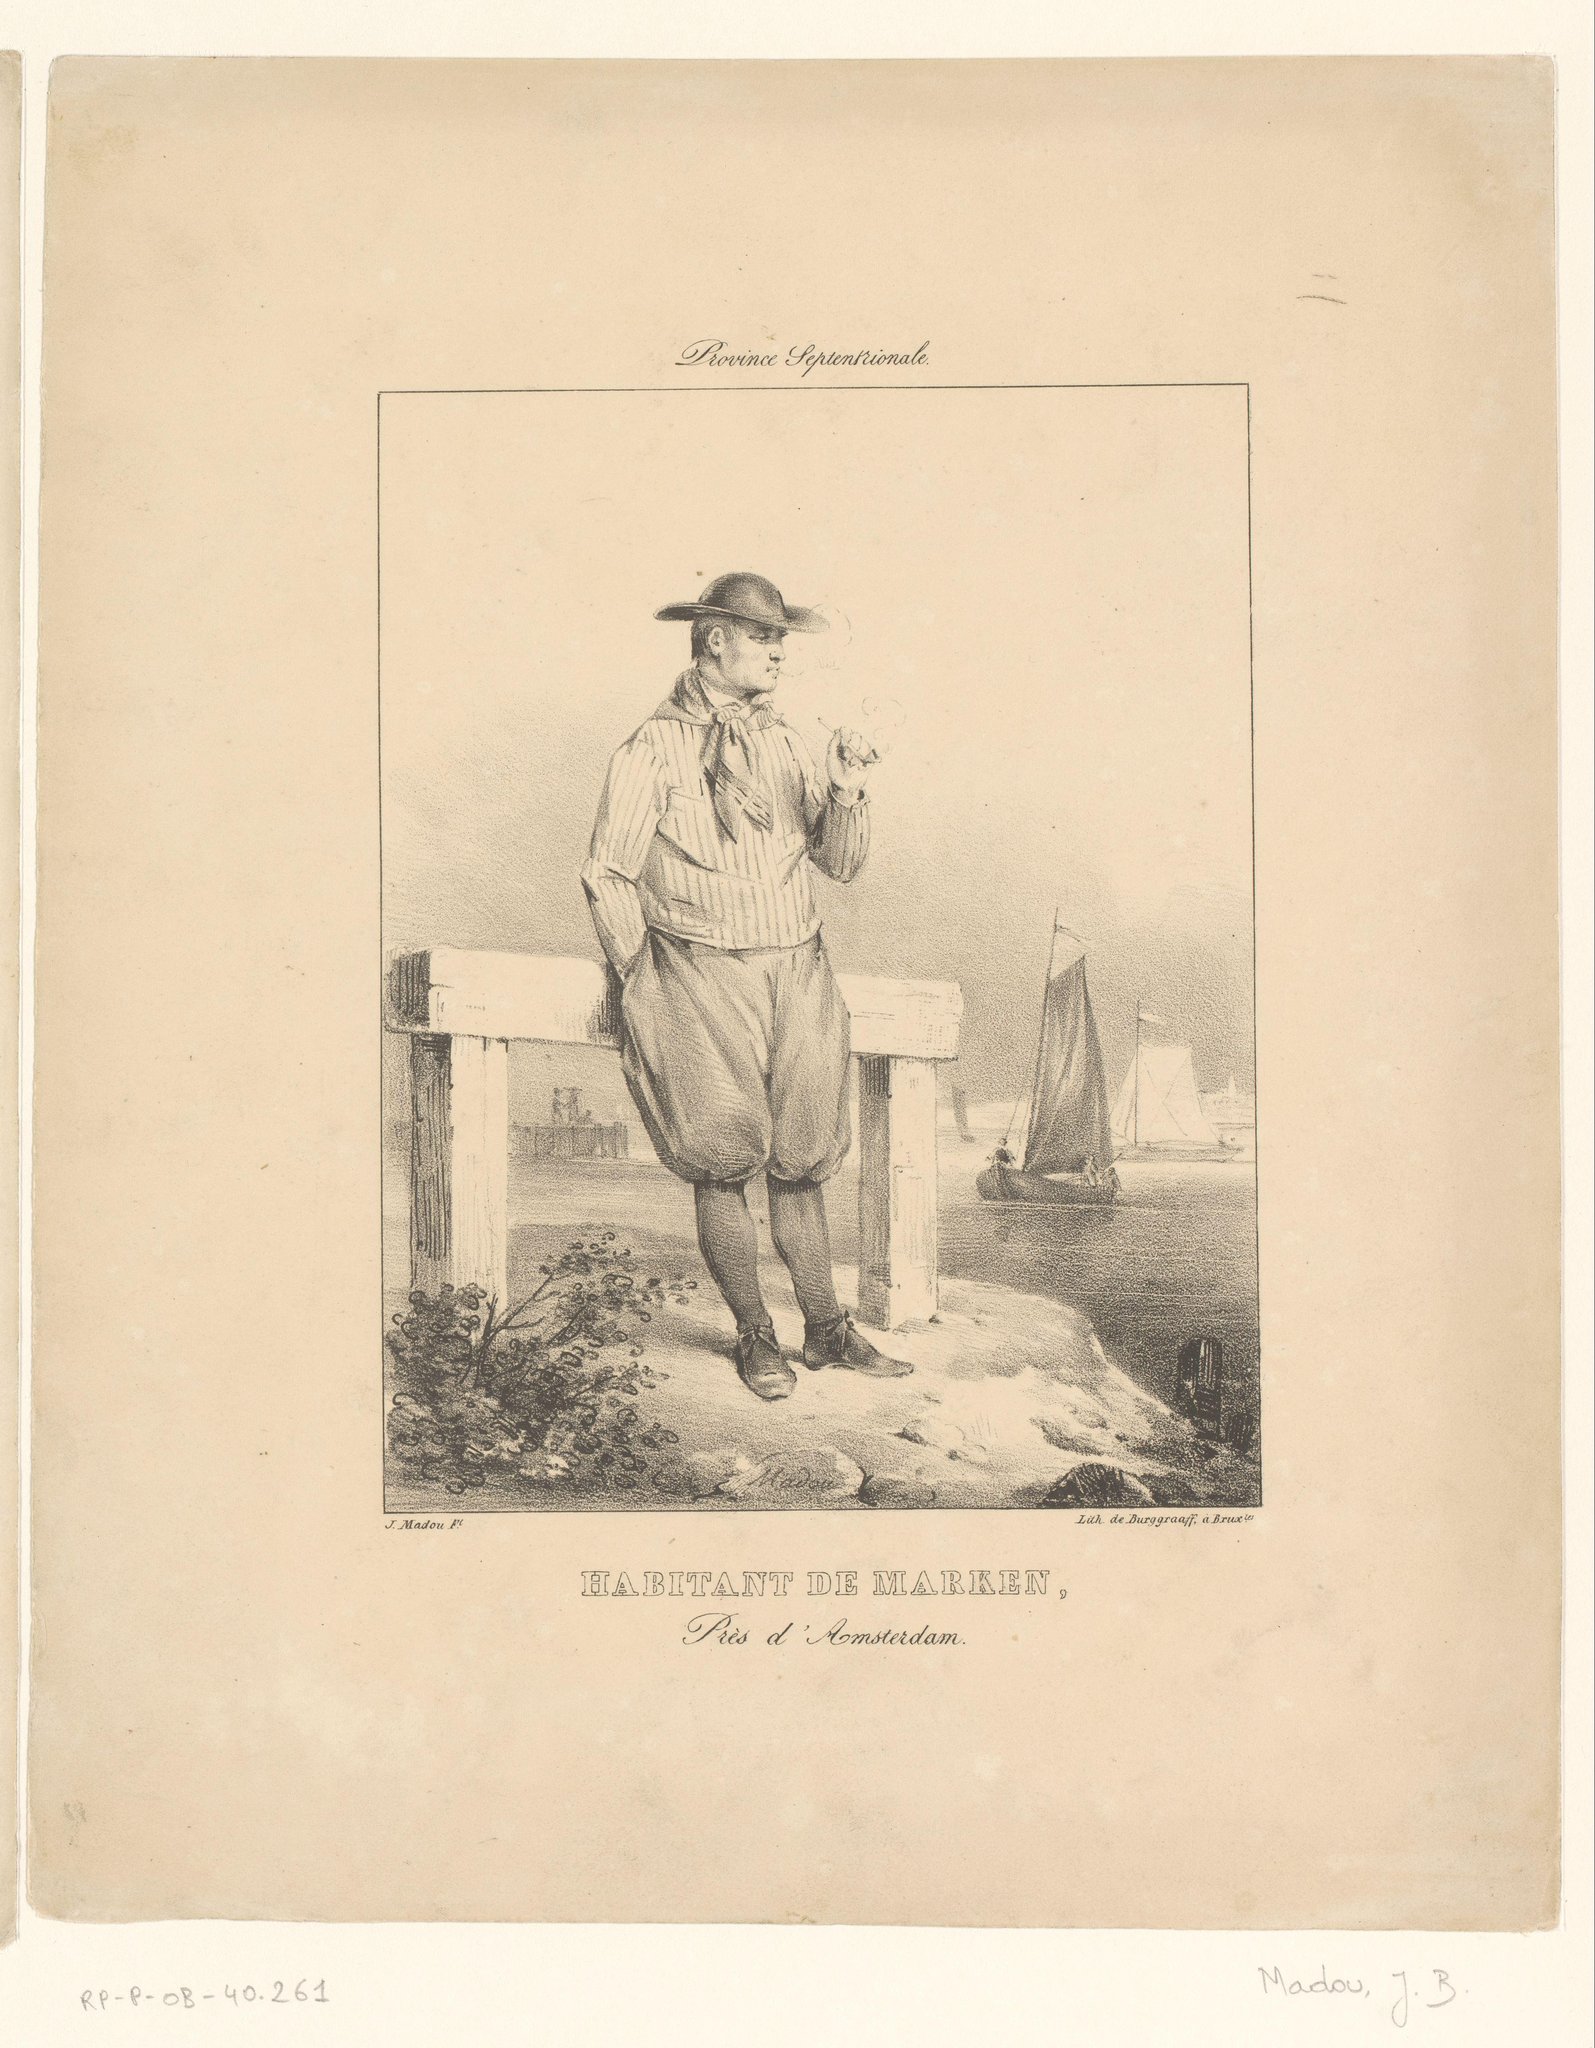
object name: print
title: Kostuums van de inwoners van Nederland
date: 1825-1835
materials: paper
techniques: lithograph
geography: brussels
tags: sailing-ship, sailing-boat, adult man, pipe ~ tobacco, folk costume, regional costume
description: Van den Burggraaff wilde een serie (twintig afleveringen met telkens vier platen) uitgeven met kostuums uit alle provincies van Nederland en België onder de titel 'Costumes du peuple de toutes les provinces des Pays-Bas'. Hij begint met deze serie in 1825 en eindigt hiermee bij de dertiende aflevering in 1830. Omdat in 1830 België zicht afsplitst van Nederland geeft hij de prenten daarna apart uit onder de titels 'Costumes de peuple Hollandais' en 'Collection de costumes du peuple des provinces de la Belgique' (1835).